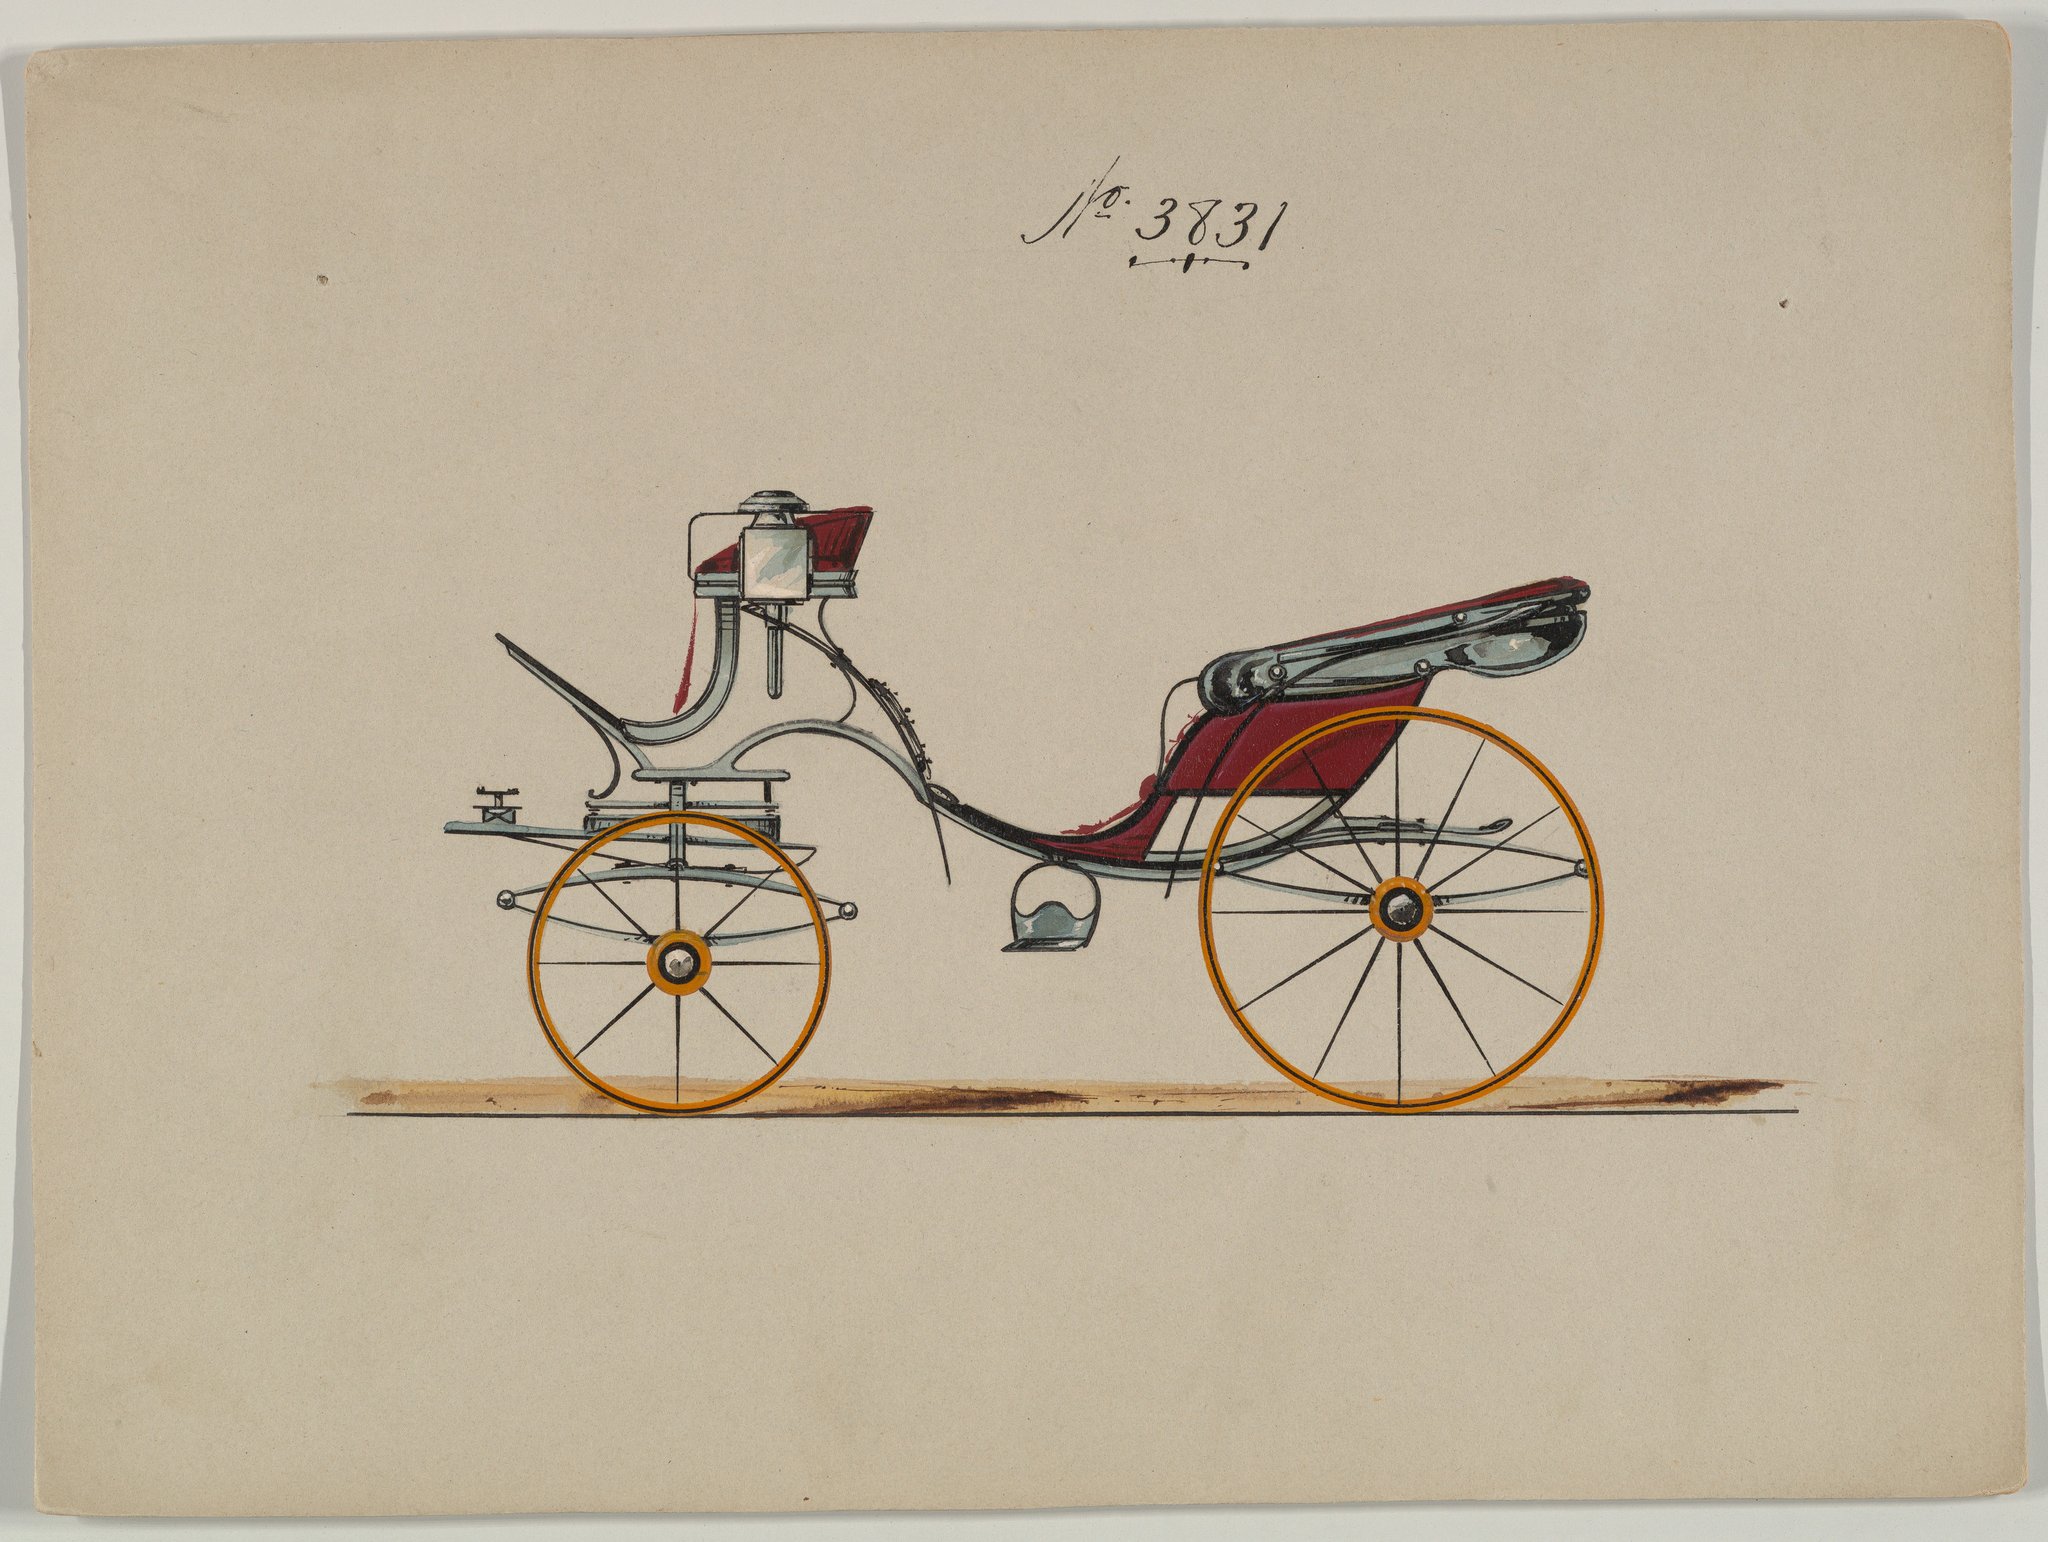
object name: drawing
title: Design for Cabriolet or Victoria, no. 3831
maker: brewster & co.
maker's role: manufacturer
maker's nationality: american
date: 1883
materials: gouache, ink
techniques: pen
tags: carriages